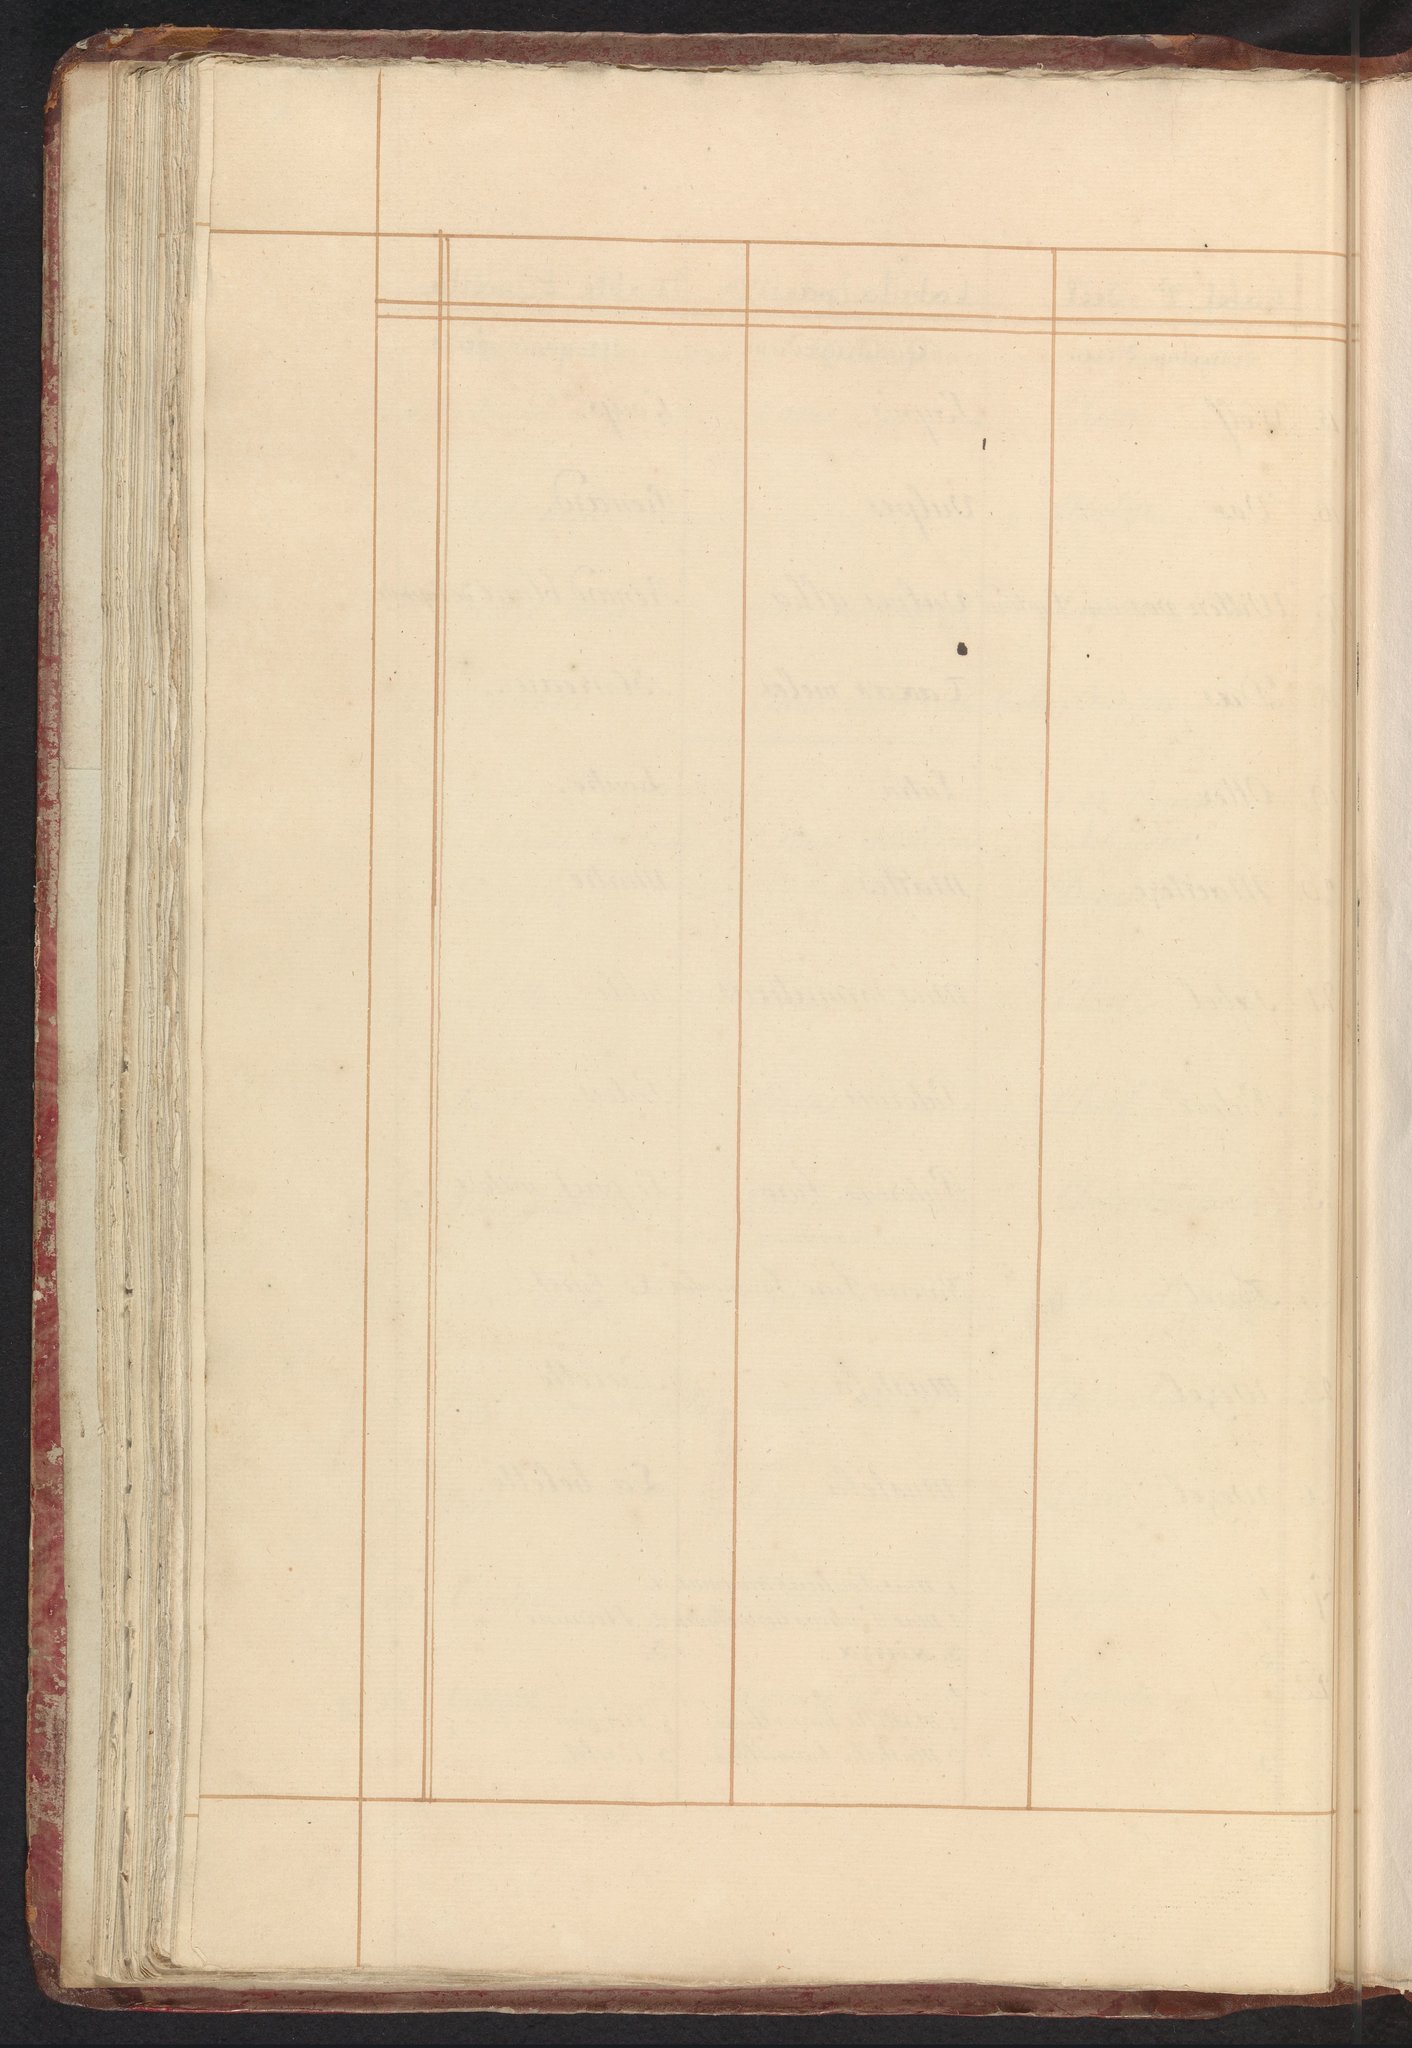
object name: drawing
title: Oningevuld schema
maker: joseph van huerne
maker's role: kunstliefhebber, mecenas, verzamelaar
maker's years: 1752-1844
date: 1809-1814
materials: ink, paper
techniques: pen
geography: bruges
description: Oningevuld schema met drie kolommen. Onderdeel van het eerste album met tekeningen van viervoeters. Eerste van twaalf albums met tekeningen van dieren, vogels en planten bekend rond 1600, gemaakt in opdracht van keizer Rudolf II. Met toelichting in Nederlands, Latijn en Frans.